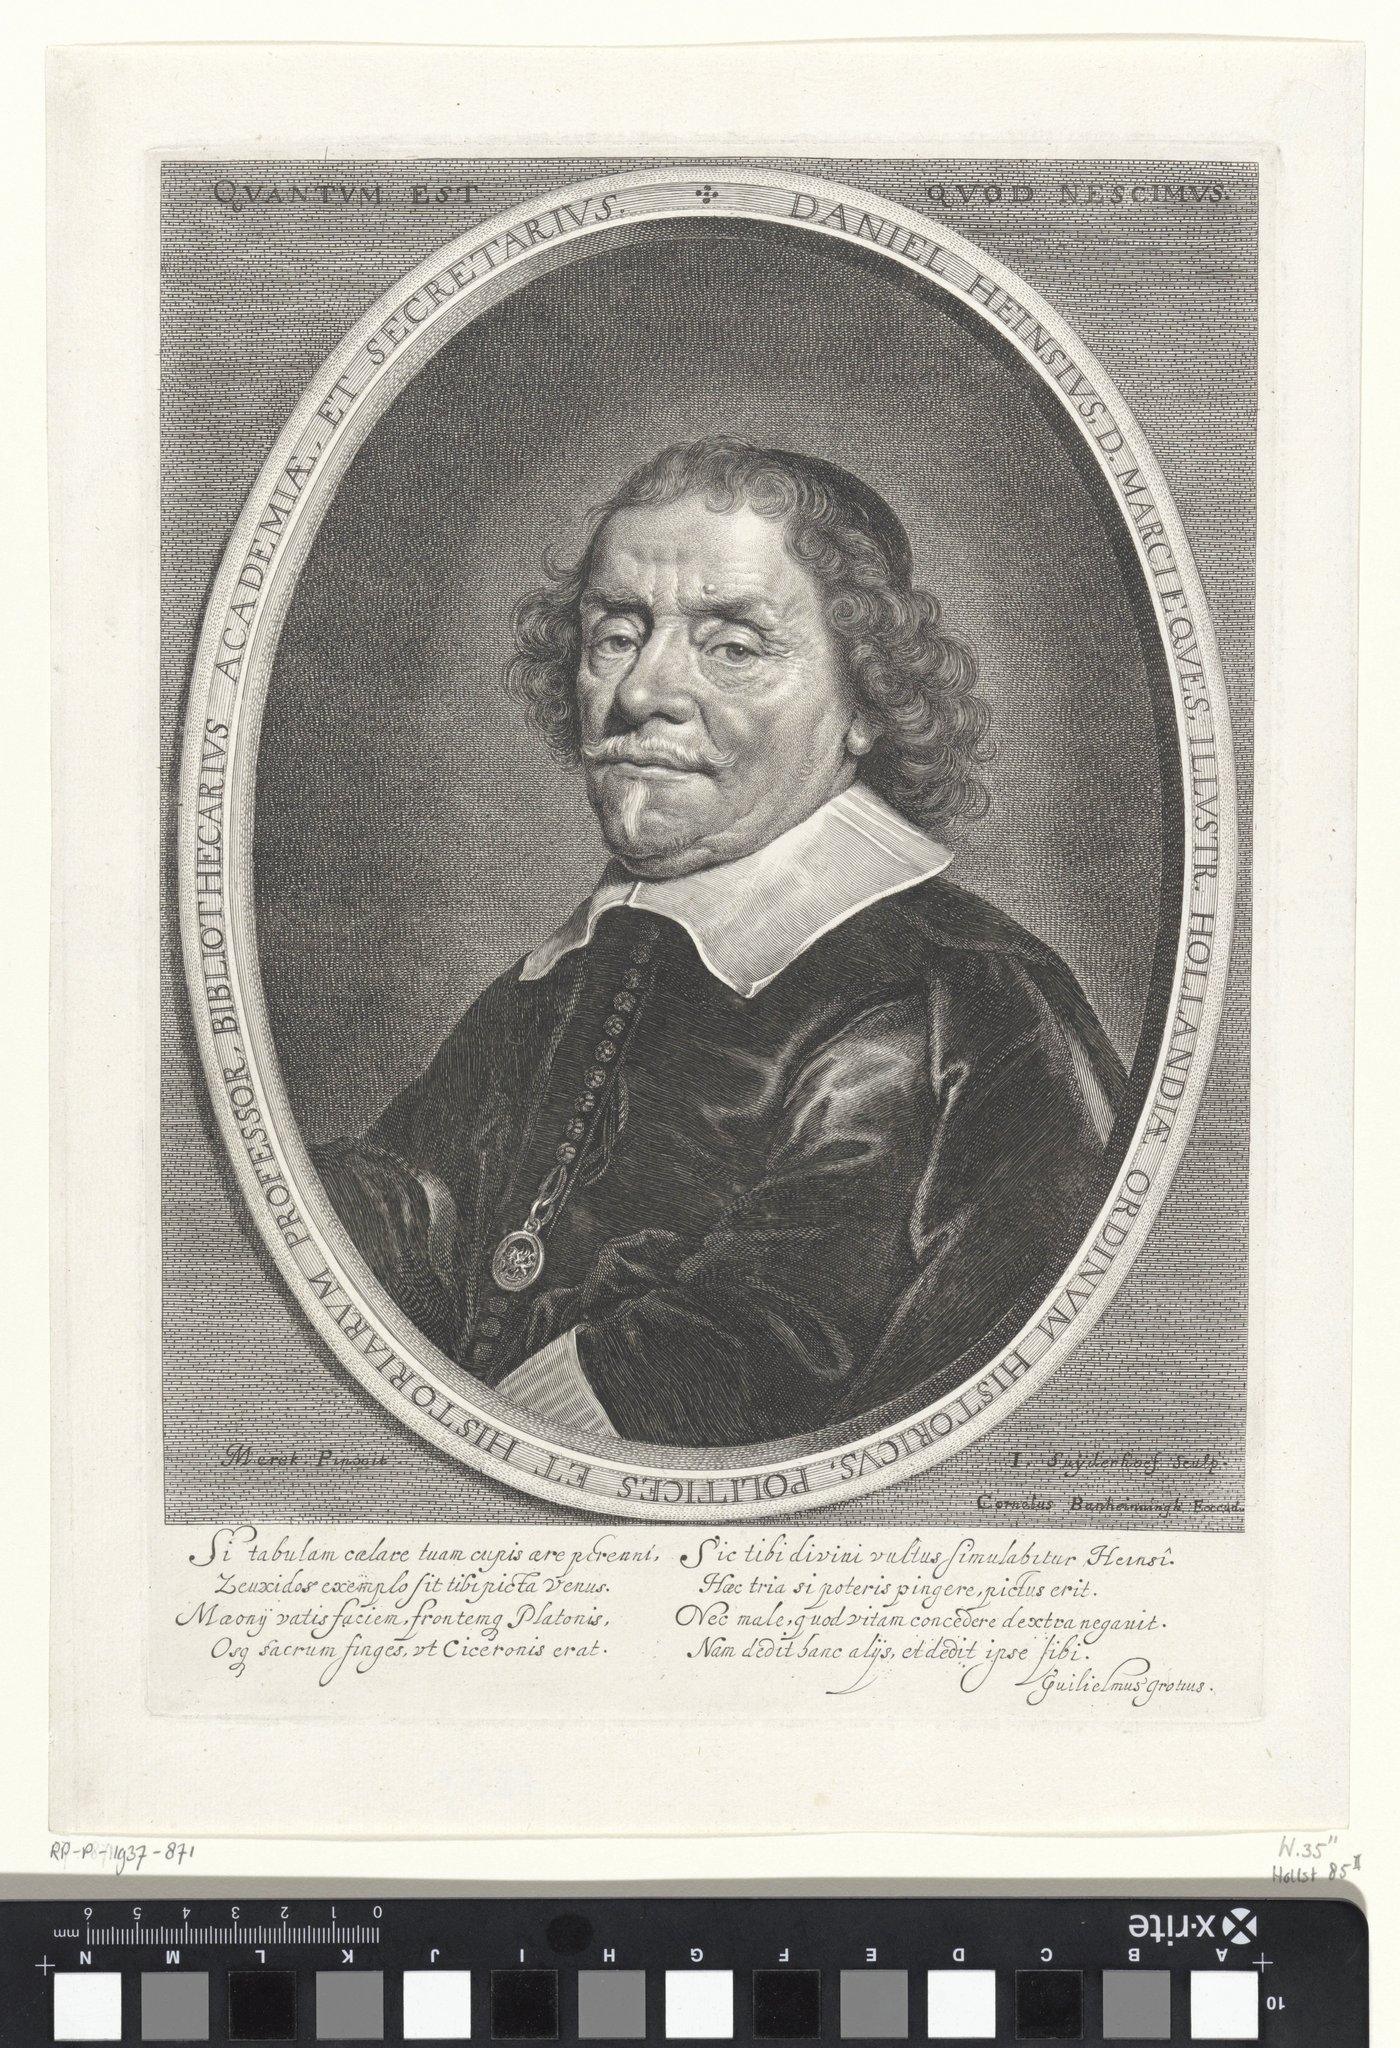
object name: print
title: Portret van Daniel Heinsius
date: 1647-1665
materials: paper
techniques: engraving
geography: haarlem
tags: ghent, leiden, daniël heinsius, professor (+ portrait of teacher, professor)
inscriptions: collector's mark: Lugt 2228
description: Portret van Daniel Heinsius, hoogleraar staatkunde en geschiedenis, universiteitsbibliothecaris en secretaris aan de universiteit van Leiden. Onderaan in de marge een twee vierregelige verzen in het Latijn.